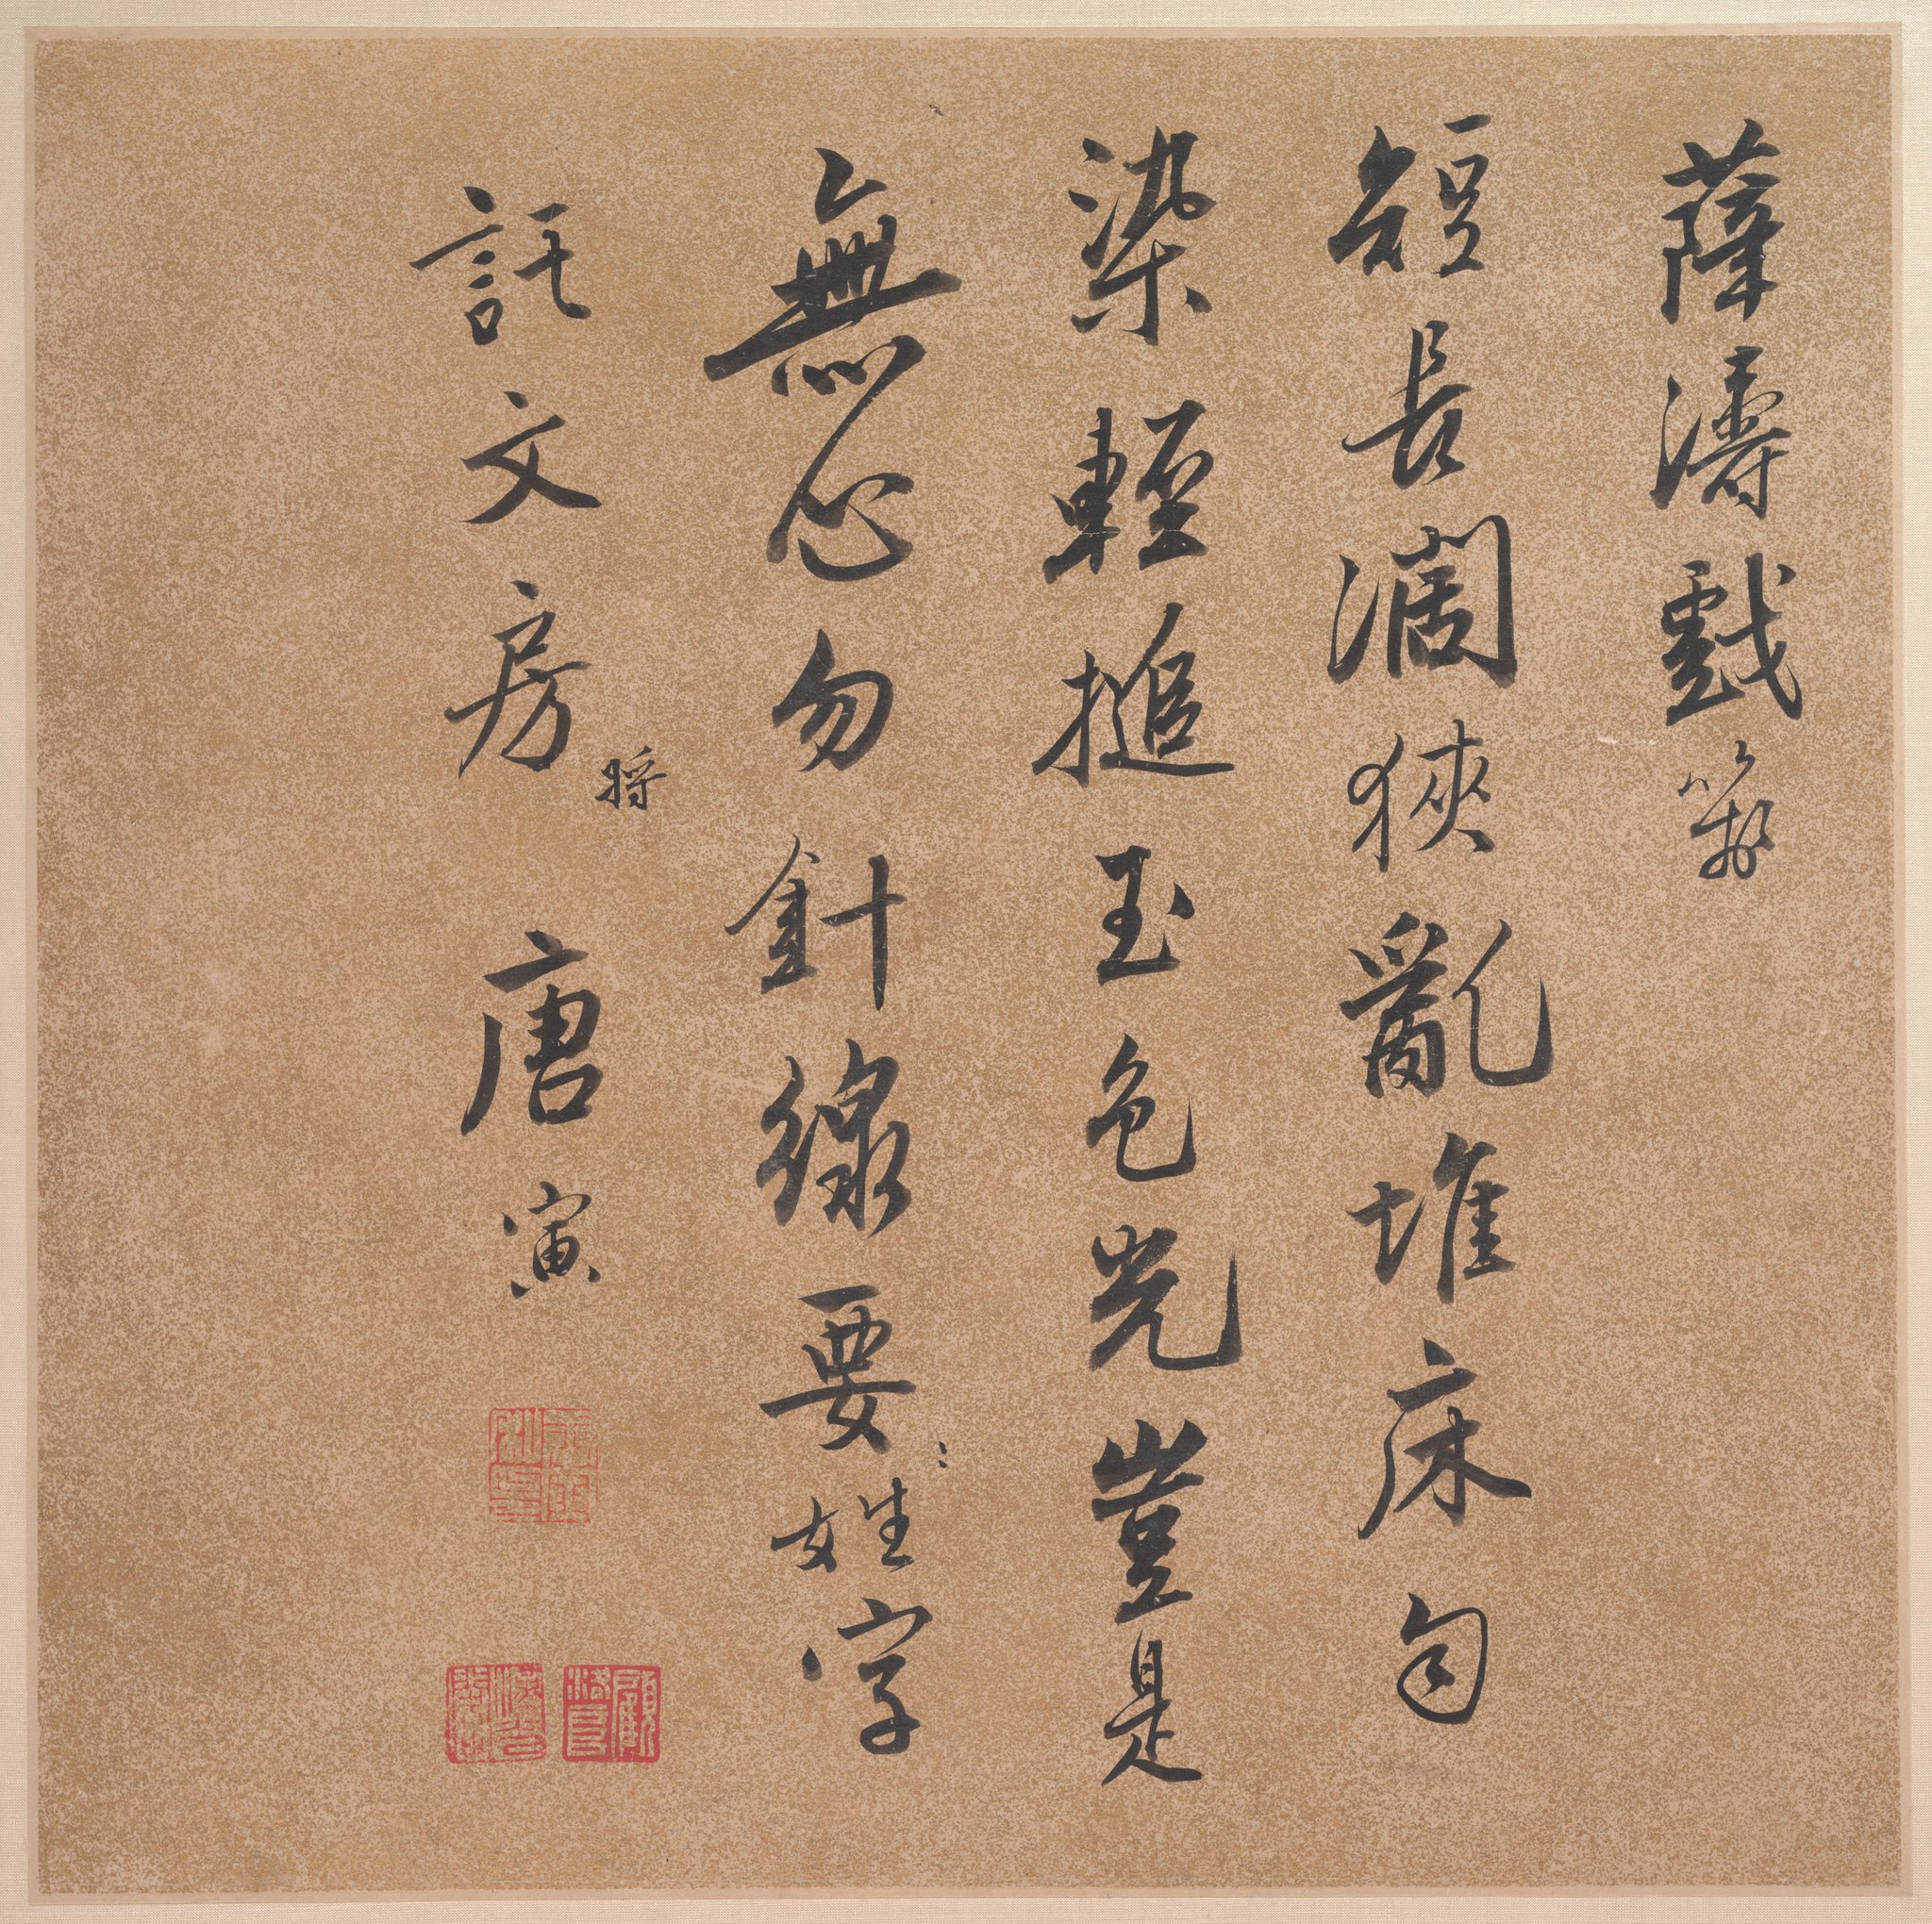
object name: album leaf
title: Calligraphy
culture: chinese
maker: tang yin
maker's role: artist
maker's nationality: chinese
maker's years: 1470-1524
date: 1470-1524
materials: gold, ink, paper